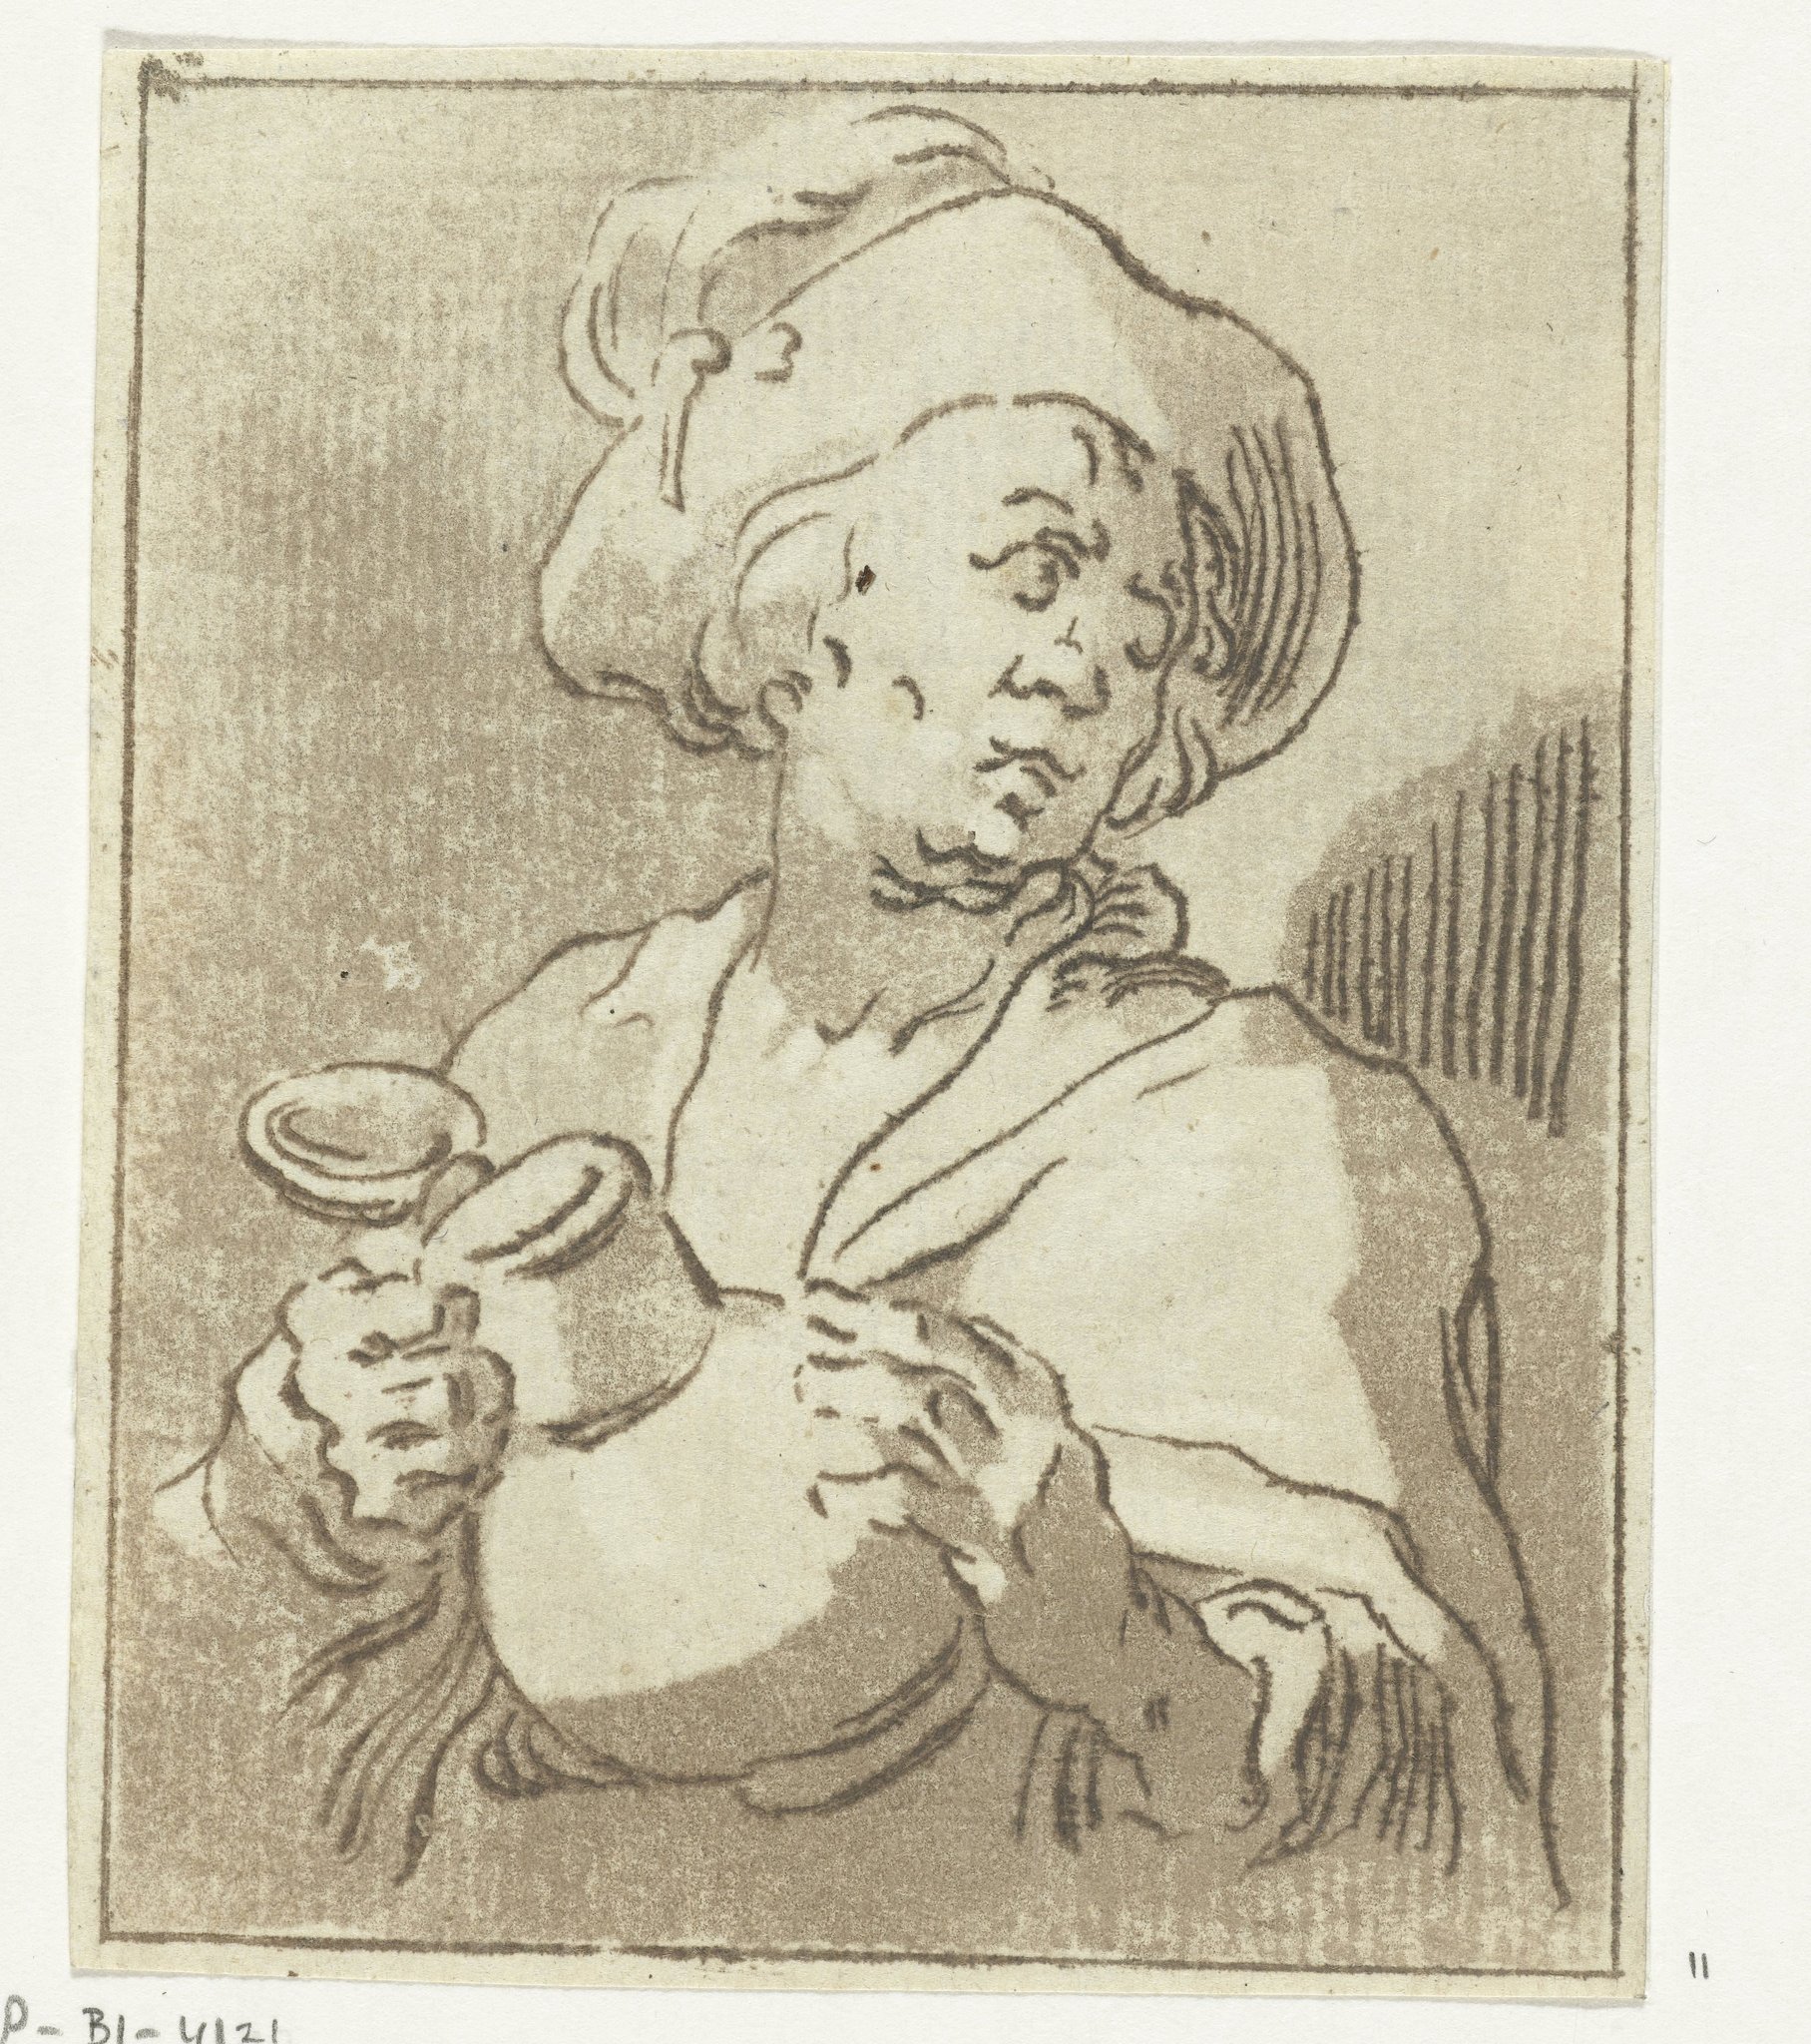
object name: print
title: Man met kruik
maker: anthonie van den bos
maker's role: draughtsman, print maker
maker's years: 1763-1838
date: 1778-1838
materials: paper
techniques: aquatint, etching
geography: netherlands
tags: jar, jug (used as drinking-vessel)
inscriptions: collector's mark: Lugt 2228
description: Een man met een pluimhoed en een kruik met deksel in zijn hand.